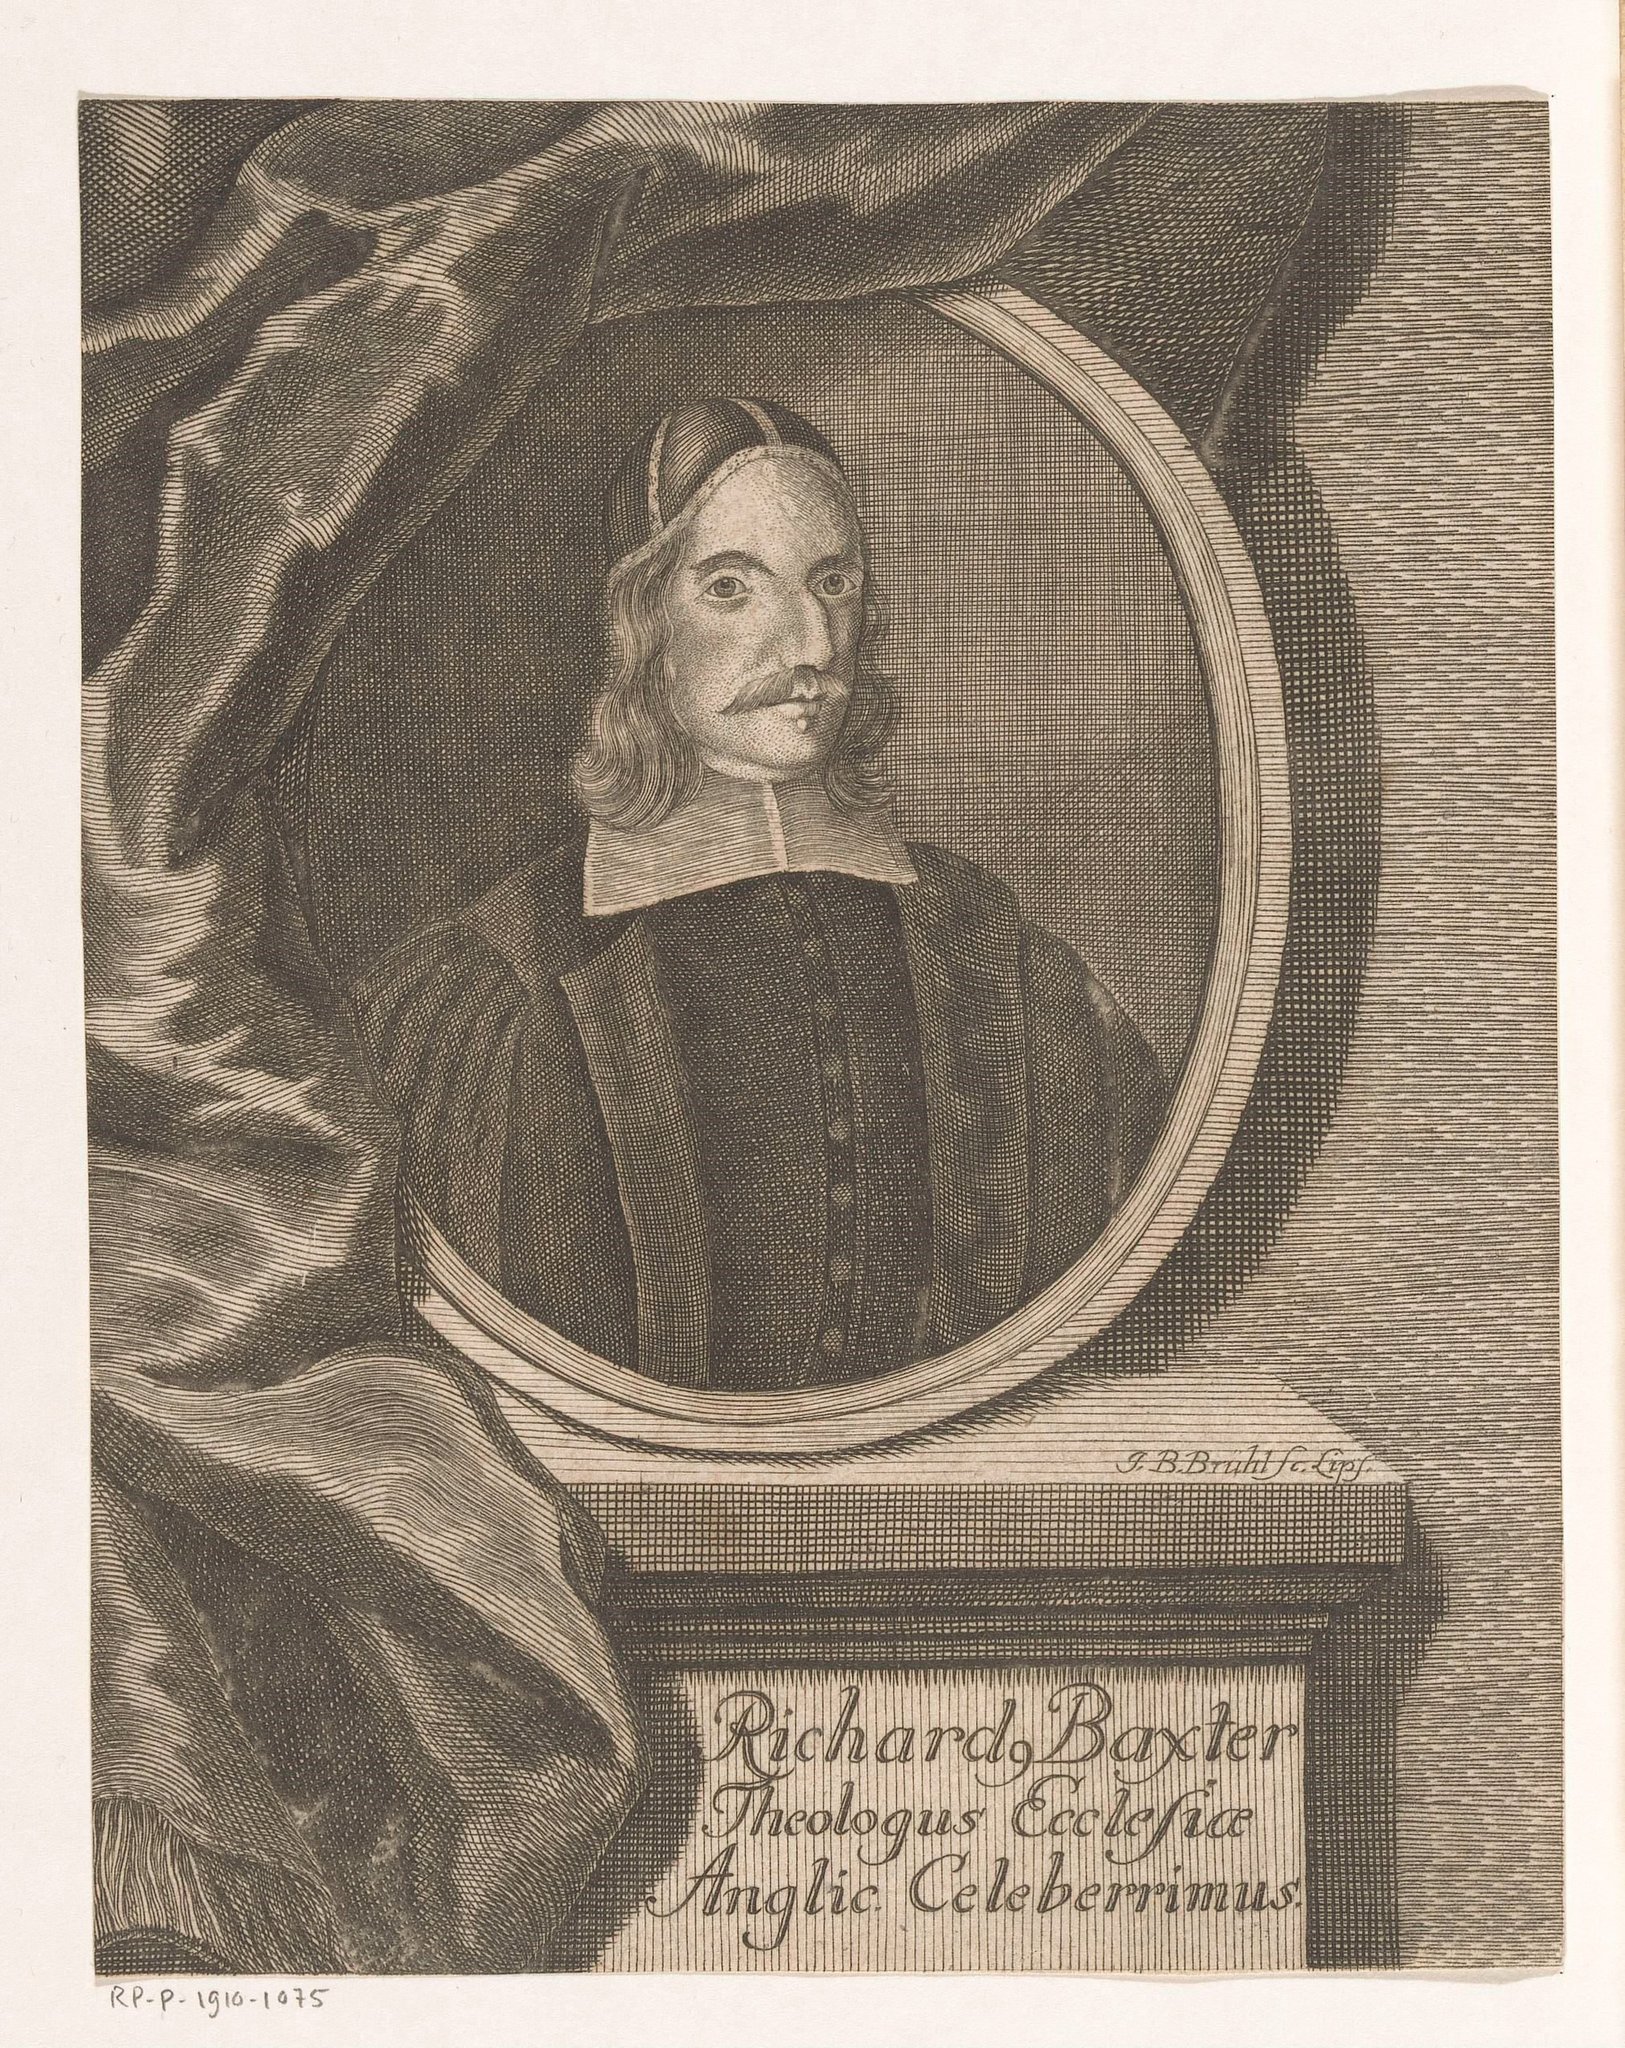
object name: print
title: Portret van Richard Baxter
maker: johann benjamin brühl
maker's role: print maker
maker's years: 1691-1763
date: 1701-1763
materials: paper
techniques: engraving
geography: leipzig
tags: london, historical persons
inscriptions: collector's mark: Lugt 2228